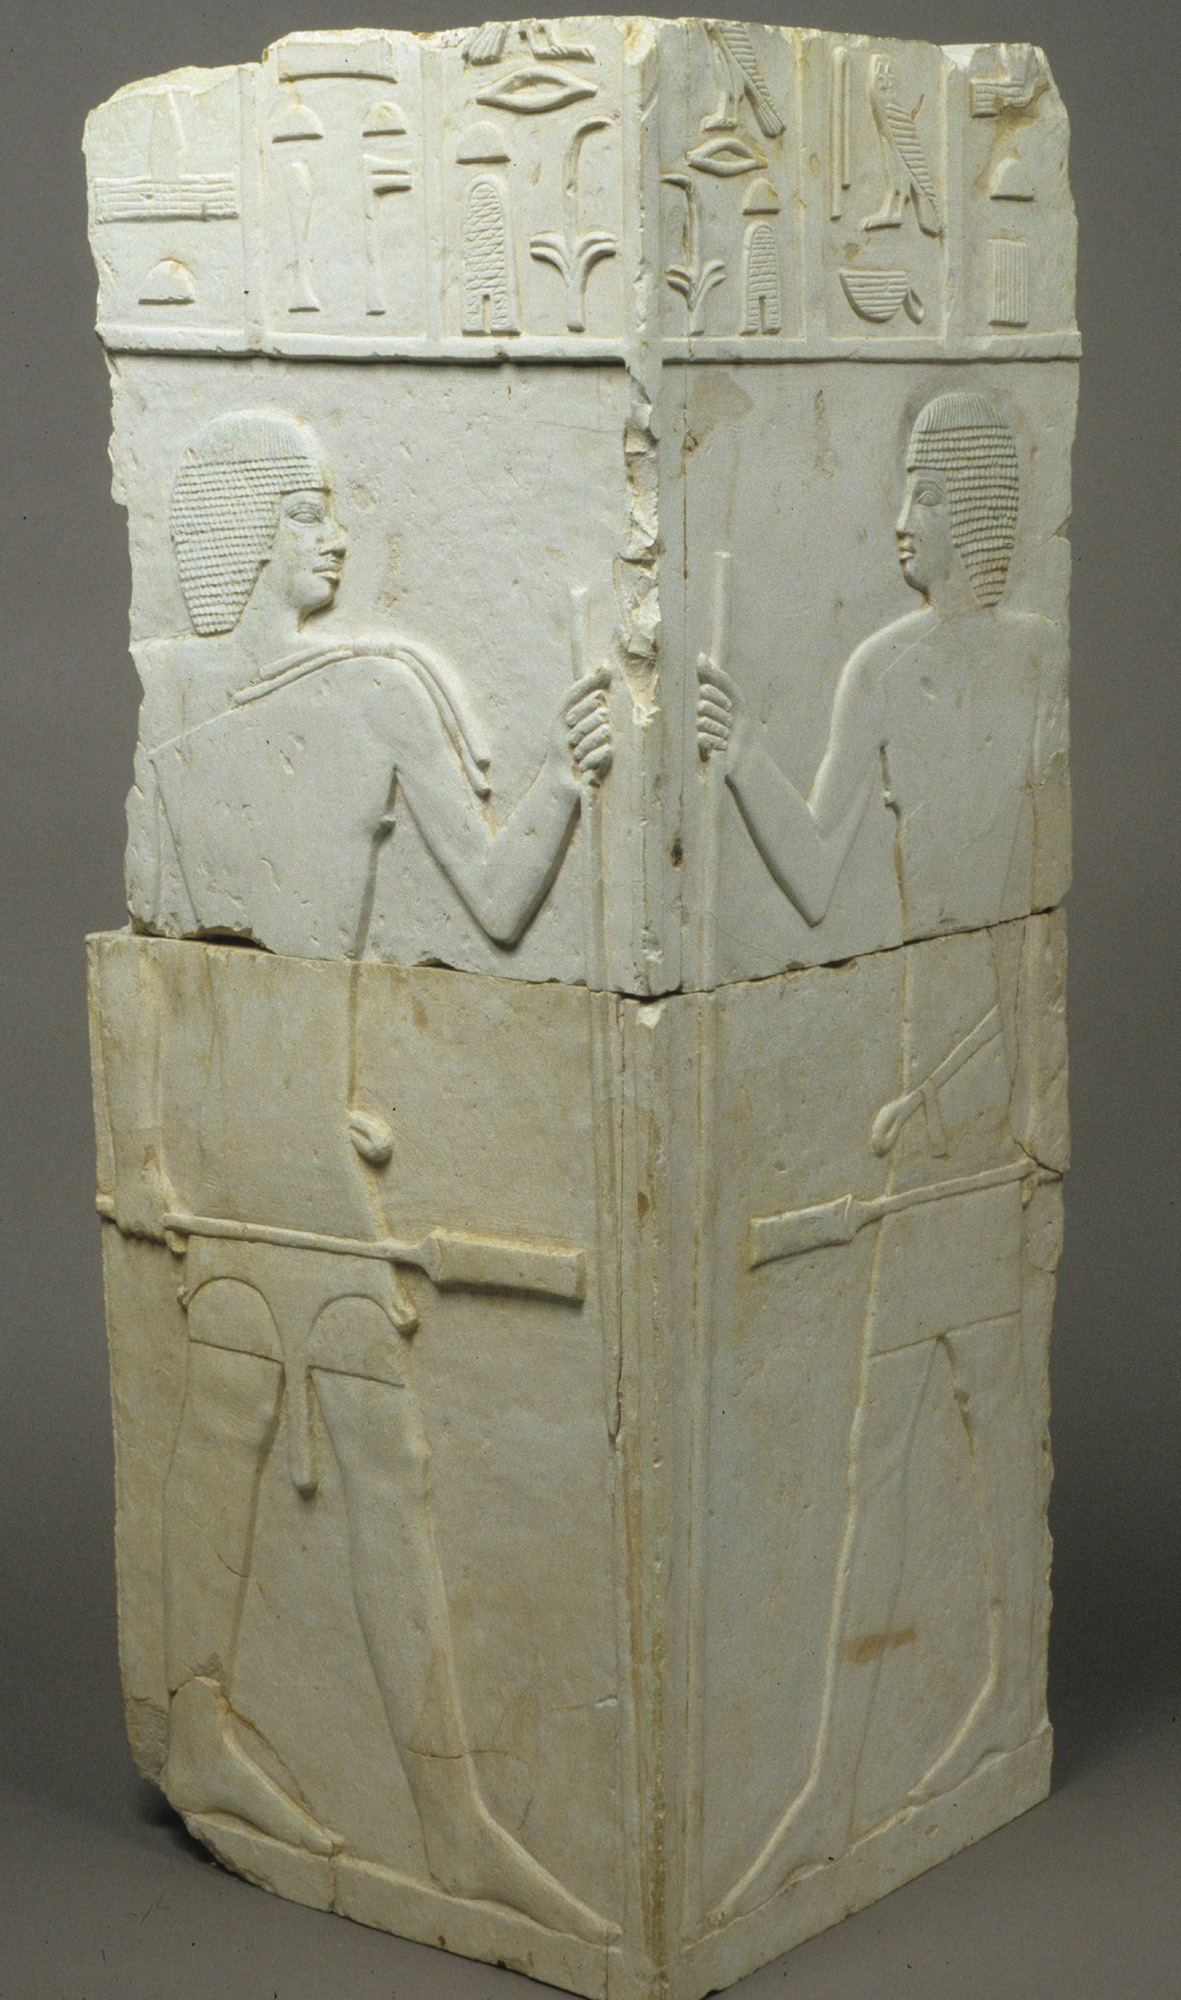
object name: false door niche block, akhtihotep, corner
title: Corner of niche from the tomb of Akhtihotep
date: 2575-2551 BCE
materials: limestone, paint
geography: egypt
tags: men,hieroglyphs